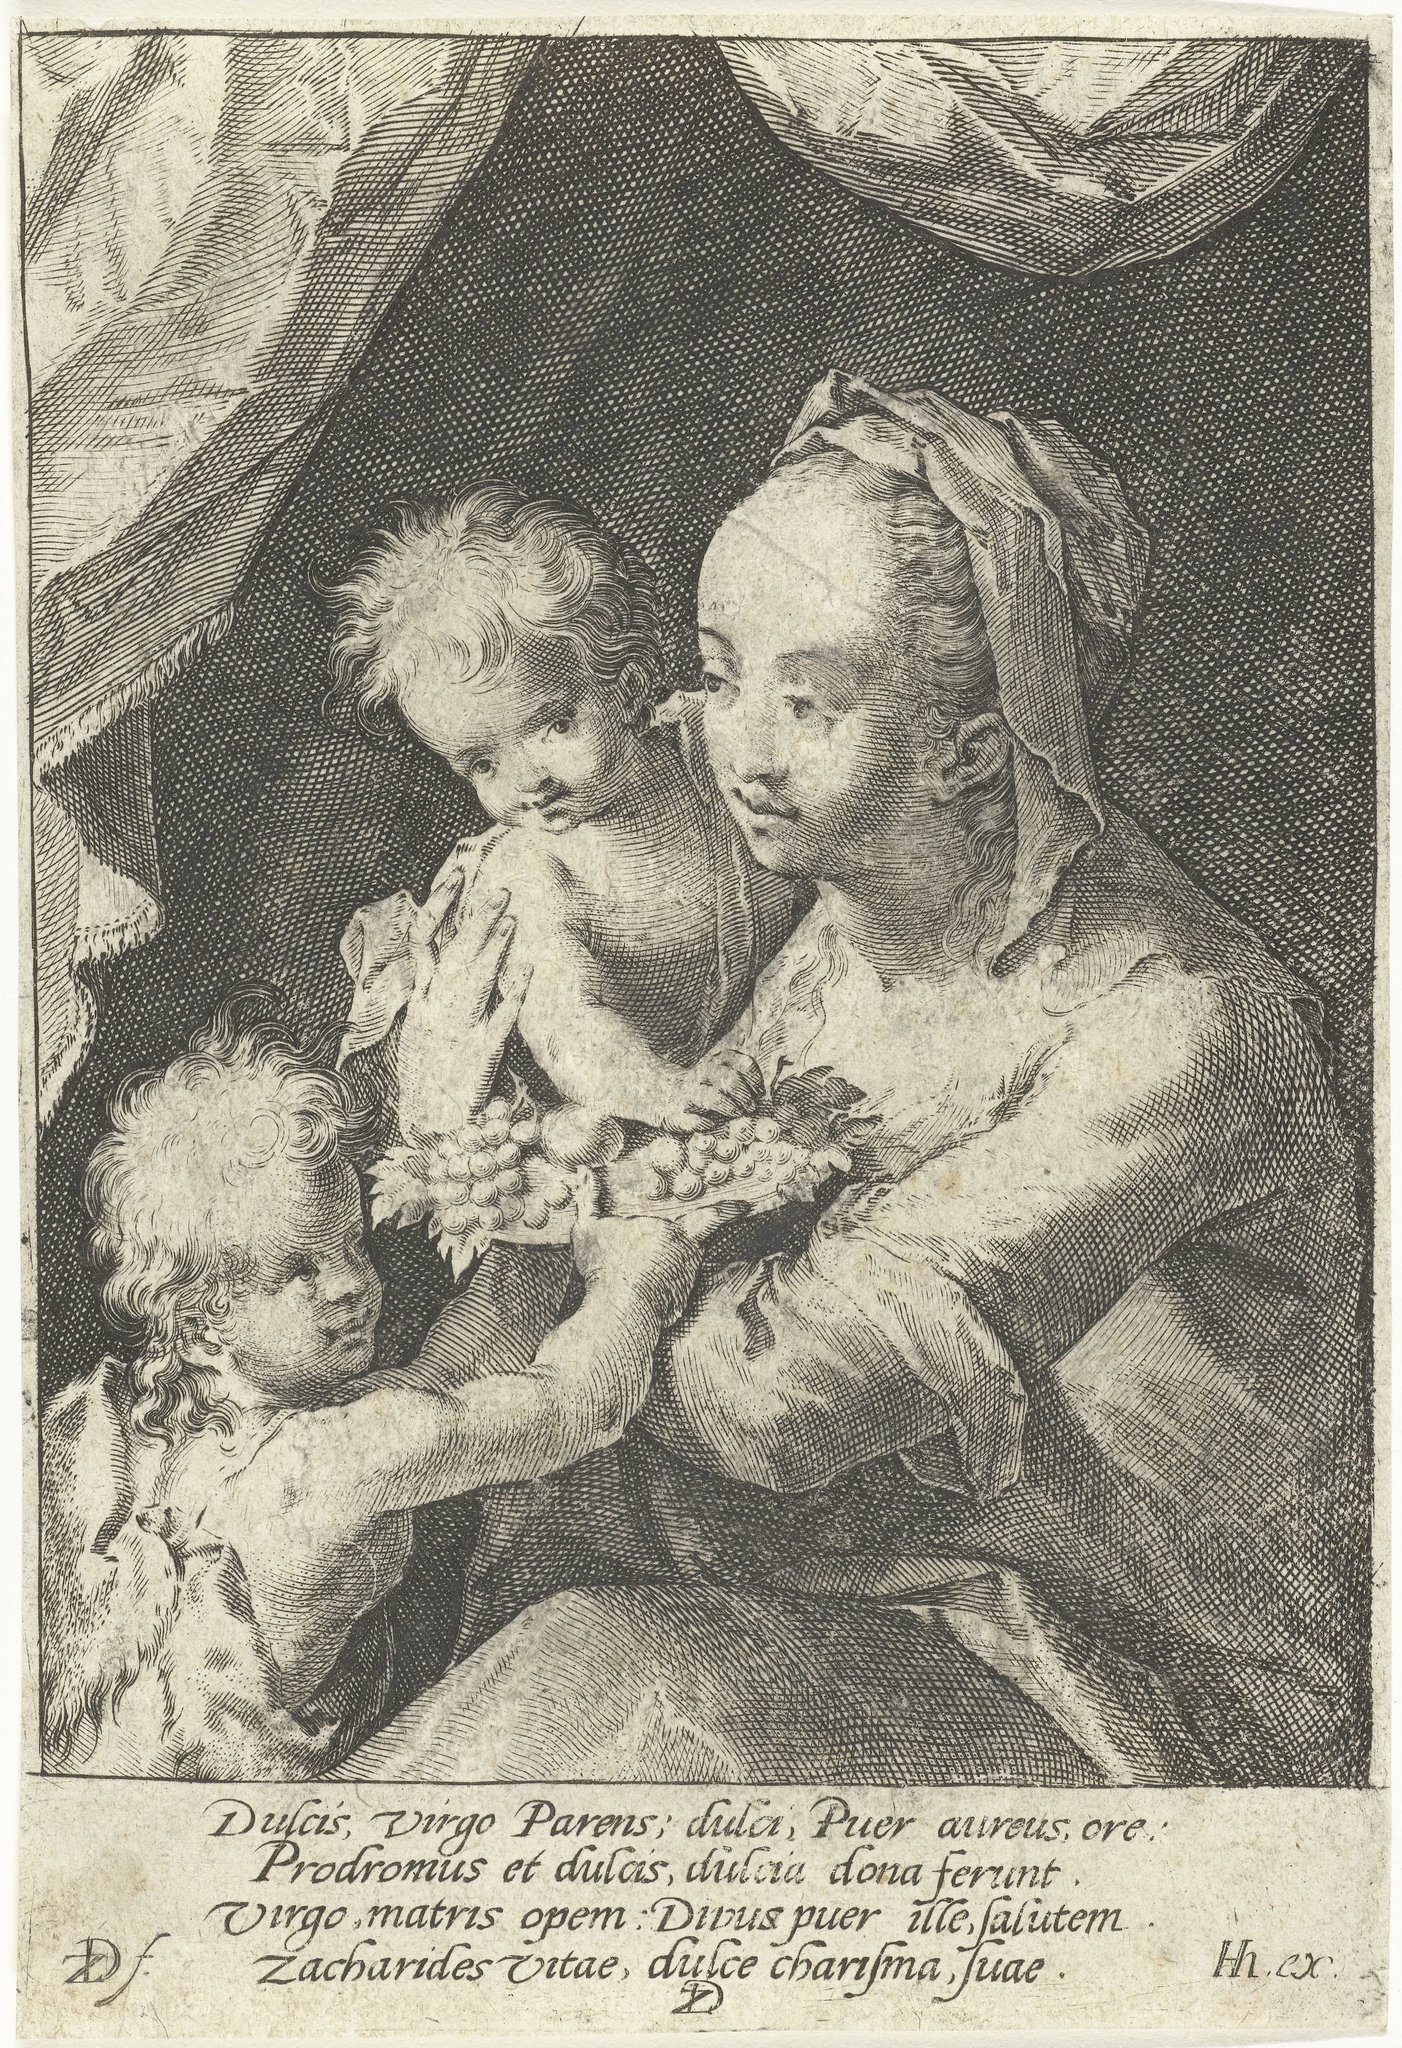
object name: print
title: Maria met Christus en Johannes de Doper als kind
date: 1590-1601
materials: paper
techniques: engraving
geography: the hague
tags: madonna: i.e. mary with the christ-child, john the baptist as child ~ madonna-representations (n.b. secondary notation only)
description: Maria houdt Christus op haar arm. Johannes de Doper als kind biedt Christus druiven en appels aan op een schaal. Het Christuskind pakt een druif. Onder de voorstelling een Latijns vers.